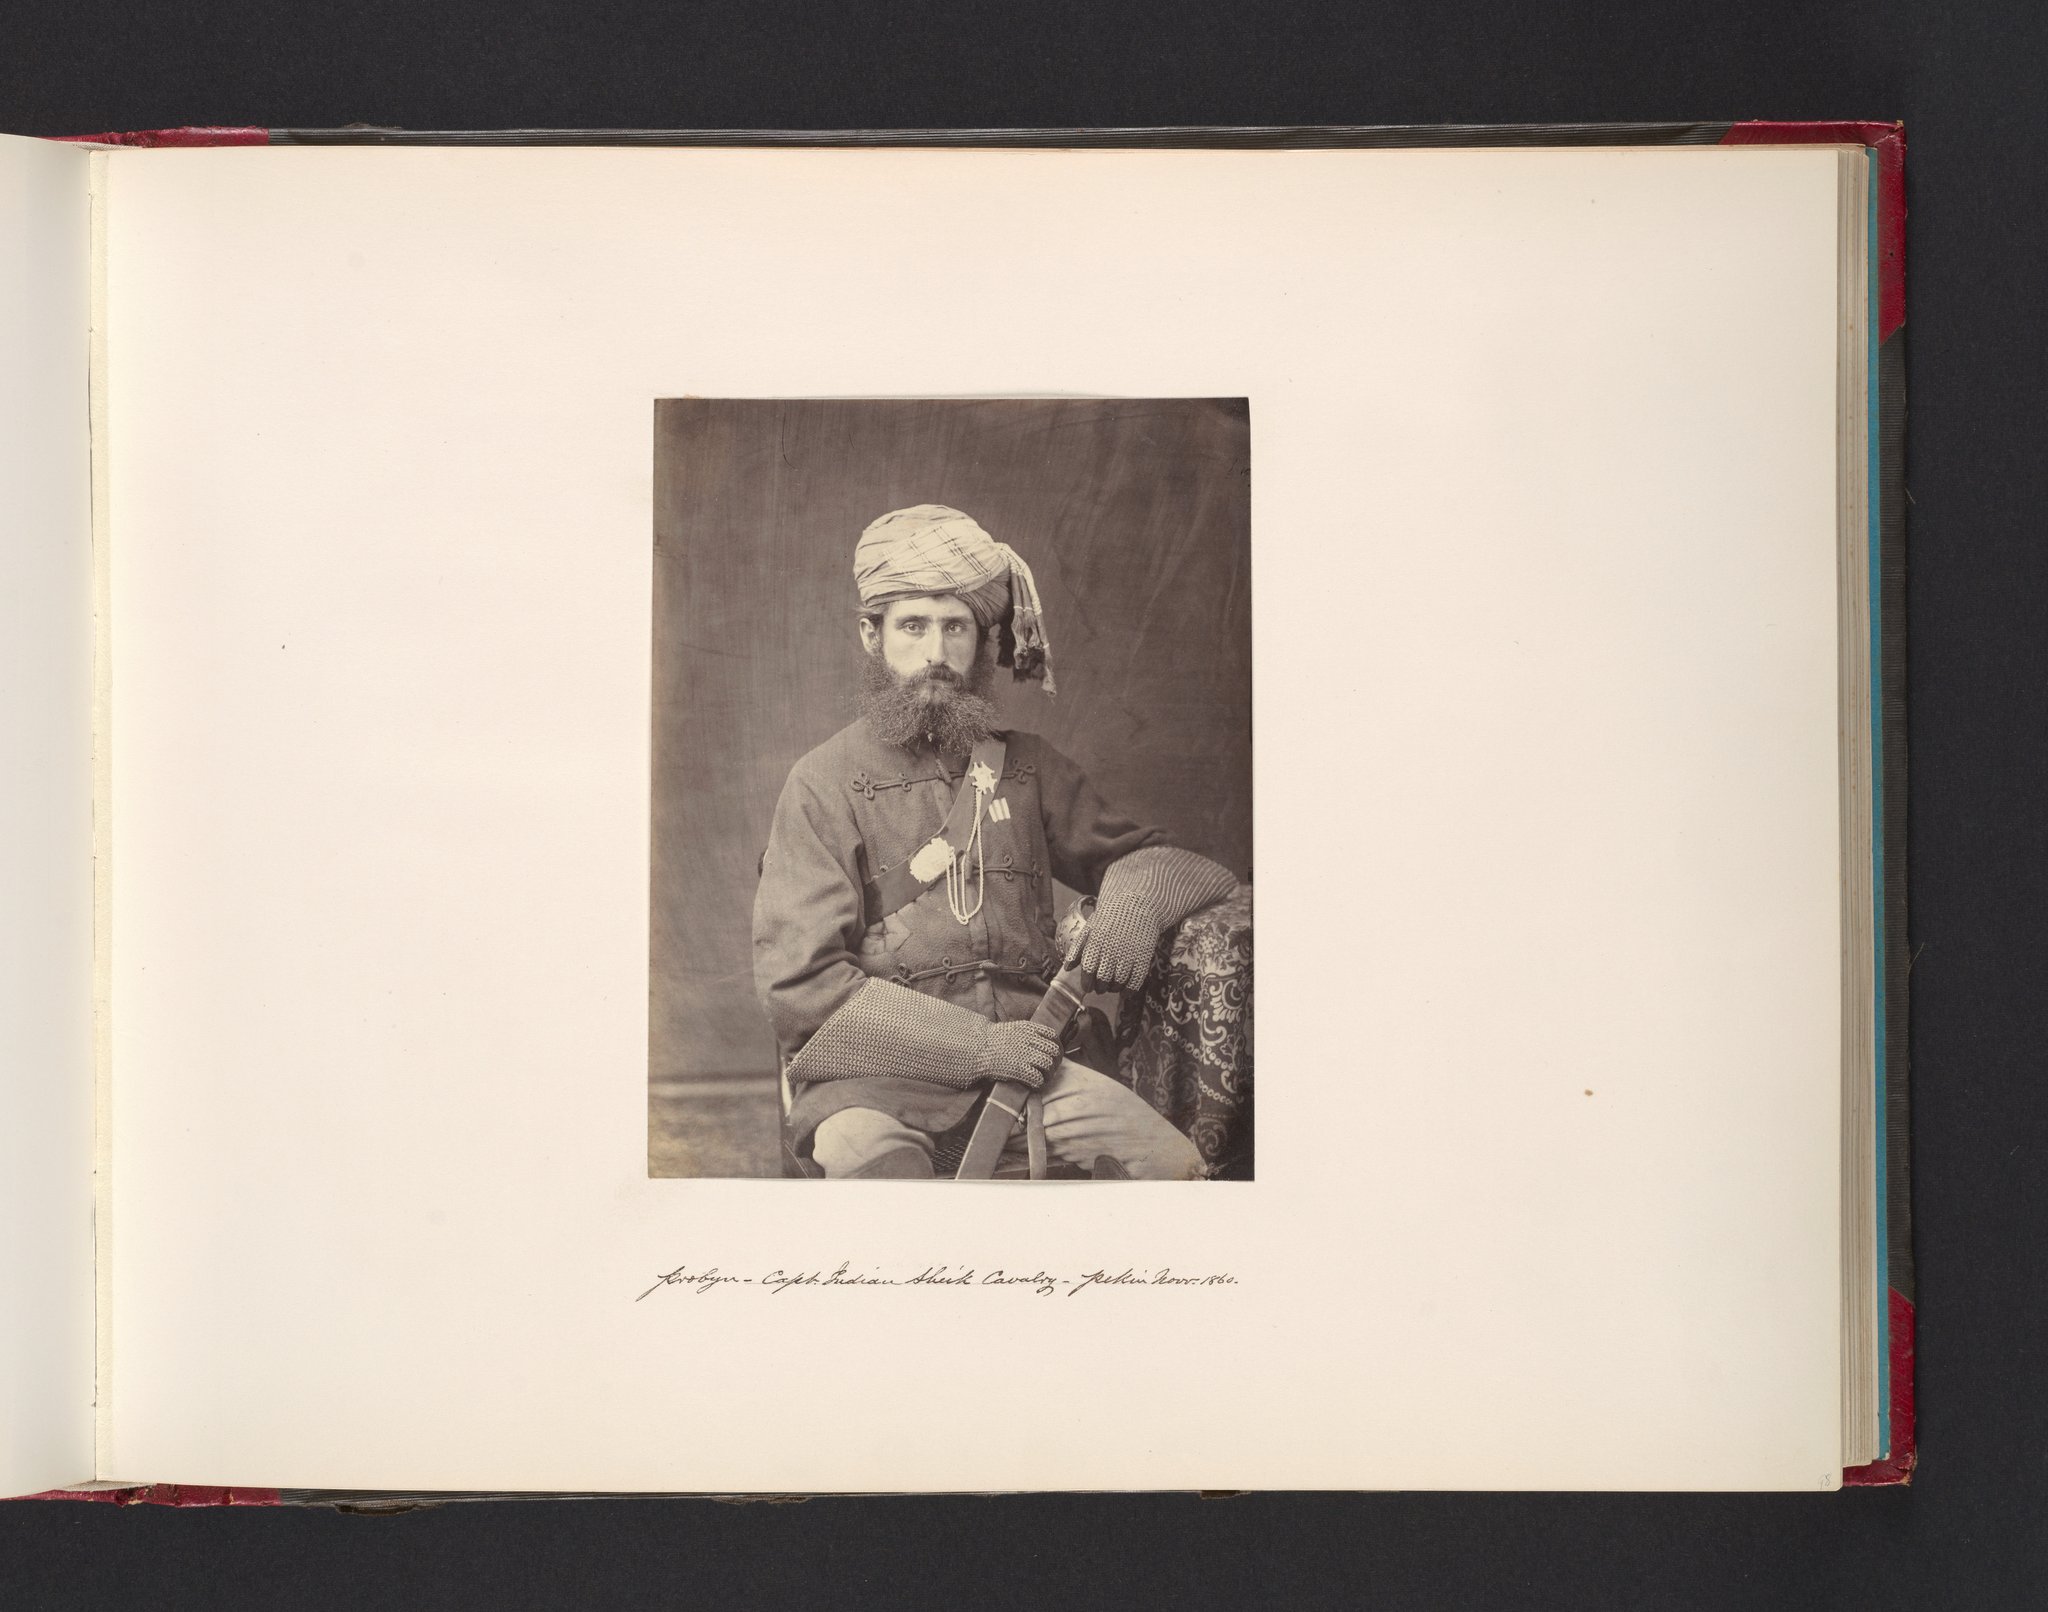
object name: photograph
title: [Captain, Indian Sheik Cavalry, Pekin]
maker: john thomson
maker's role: artist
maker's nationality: british, scottish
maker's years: 1837-1921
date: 1860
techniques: albumen silver print, glass negative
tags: men,portraits